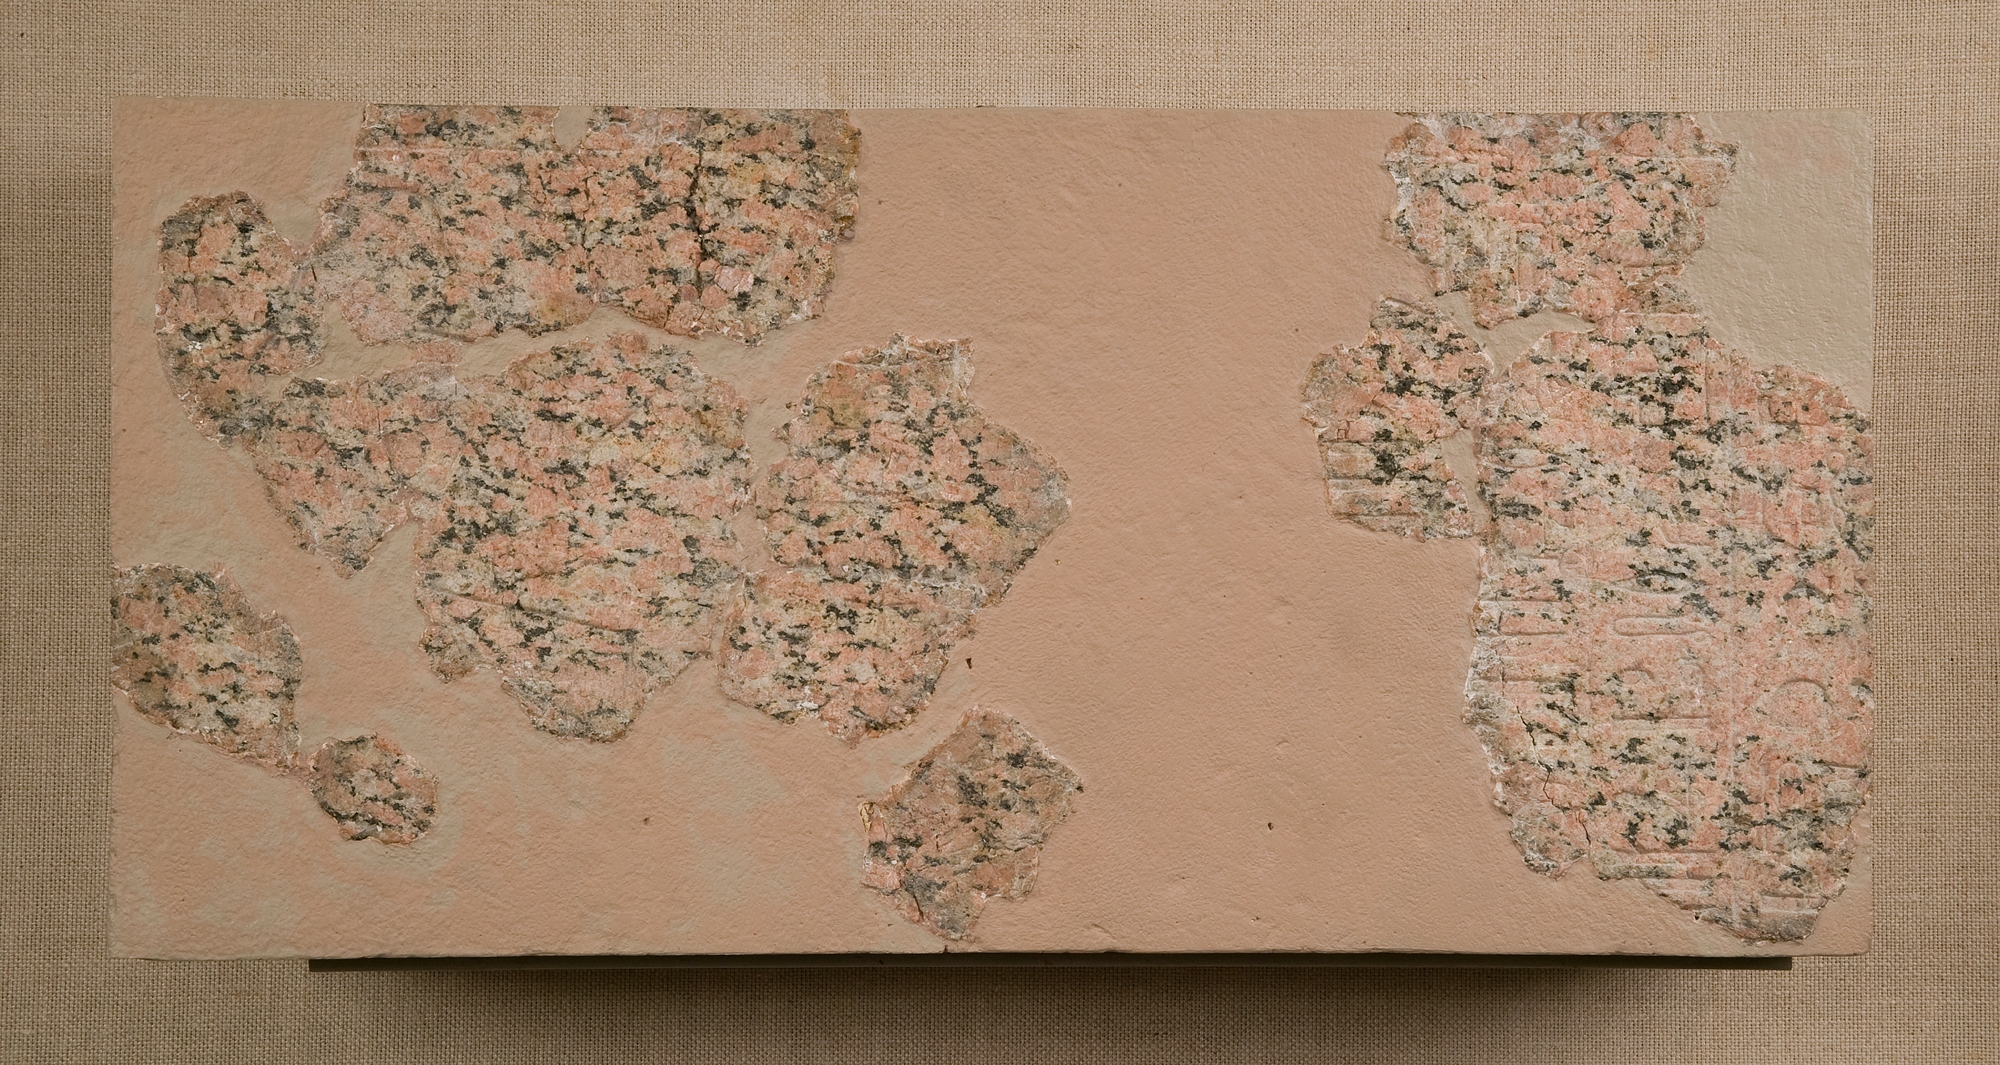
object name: door lintel, senwosretankh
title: Lintel of Senwosretankh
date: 1920-1900 BCE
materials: granite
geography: egypt